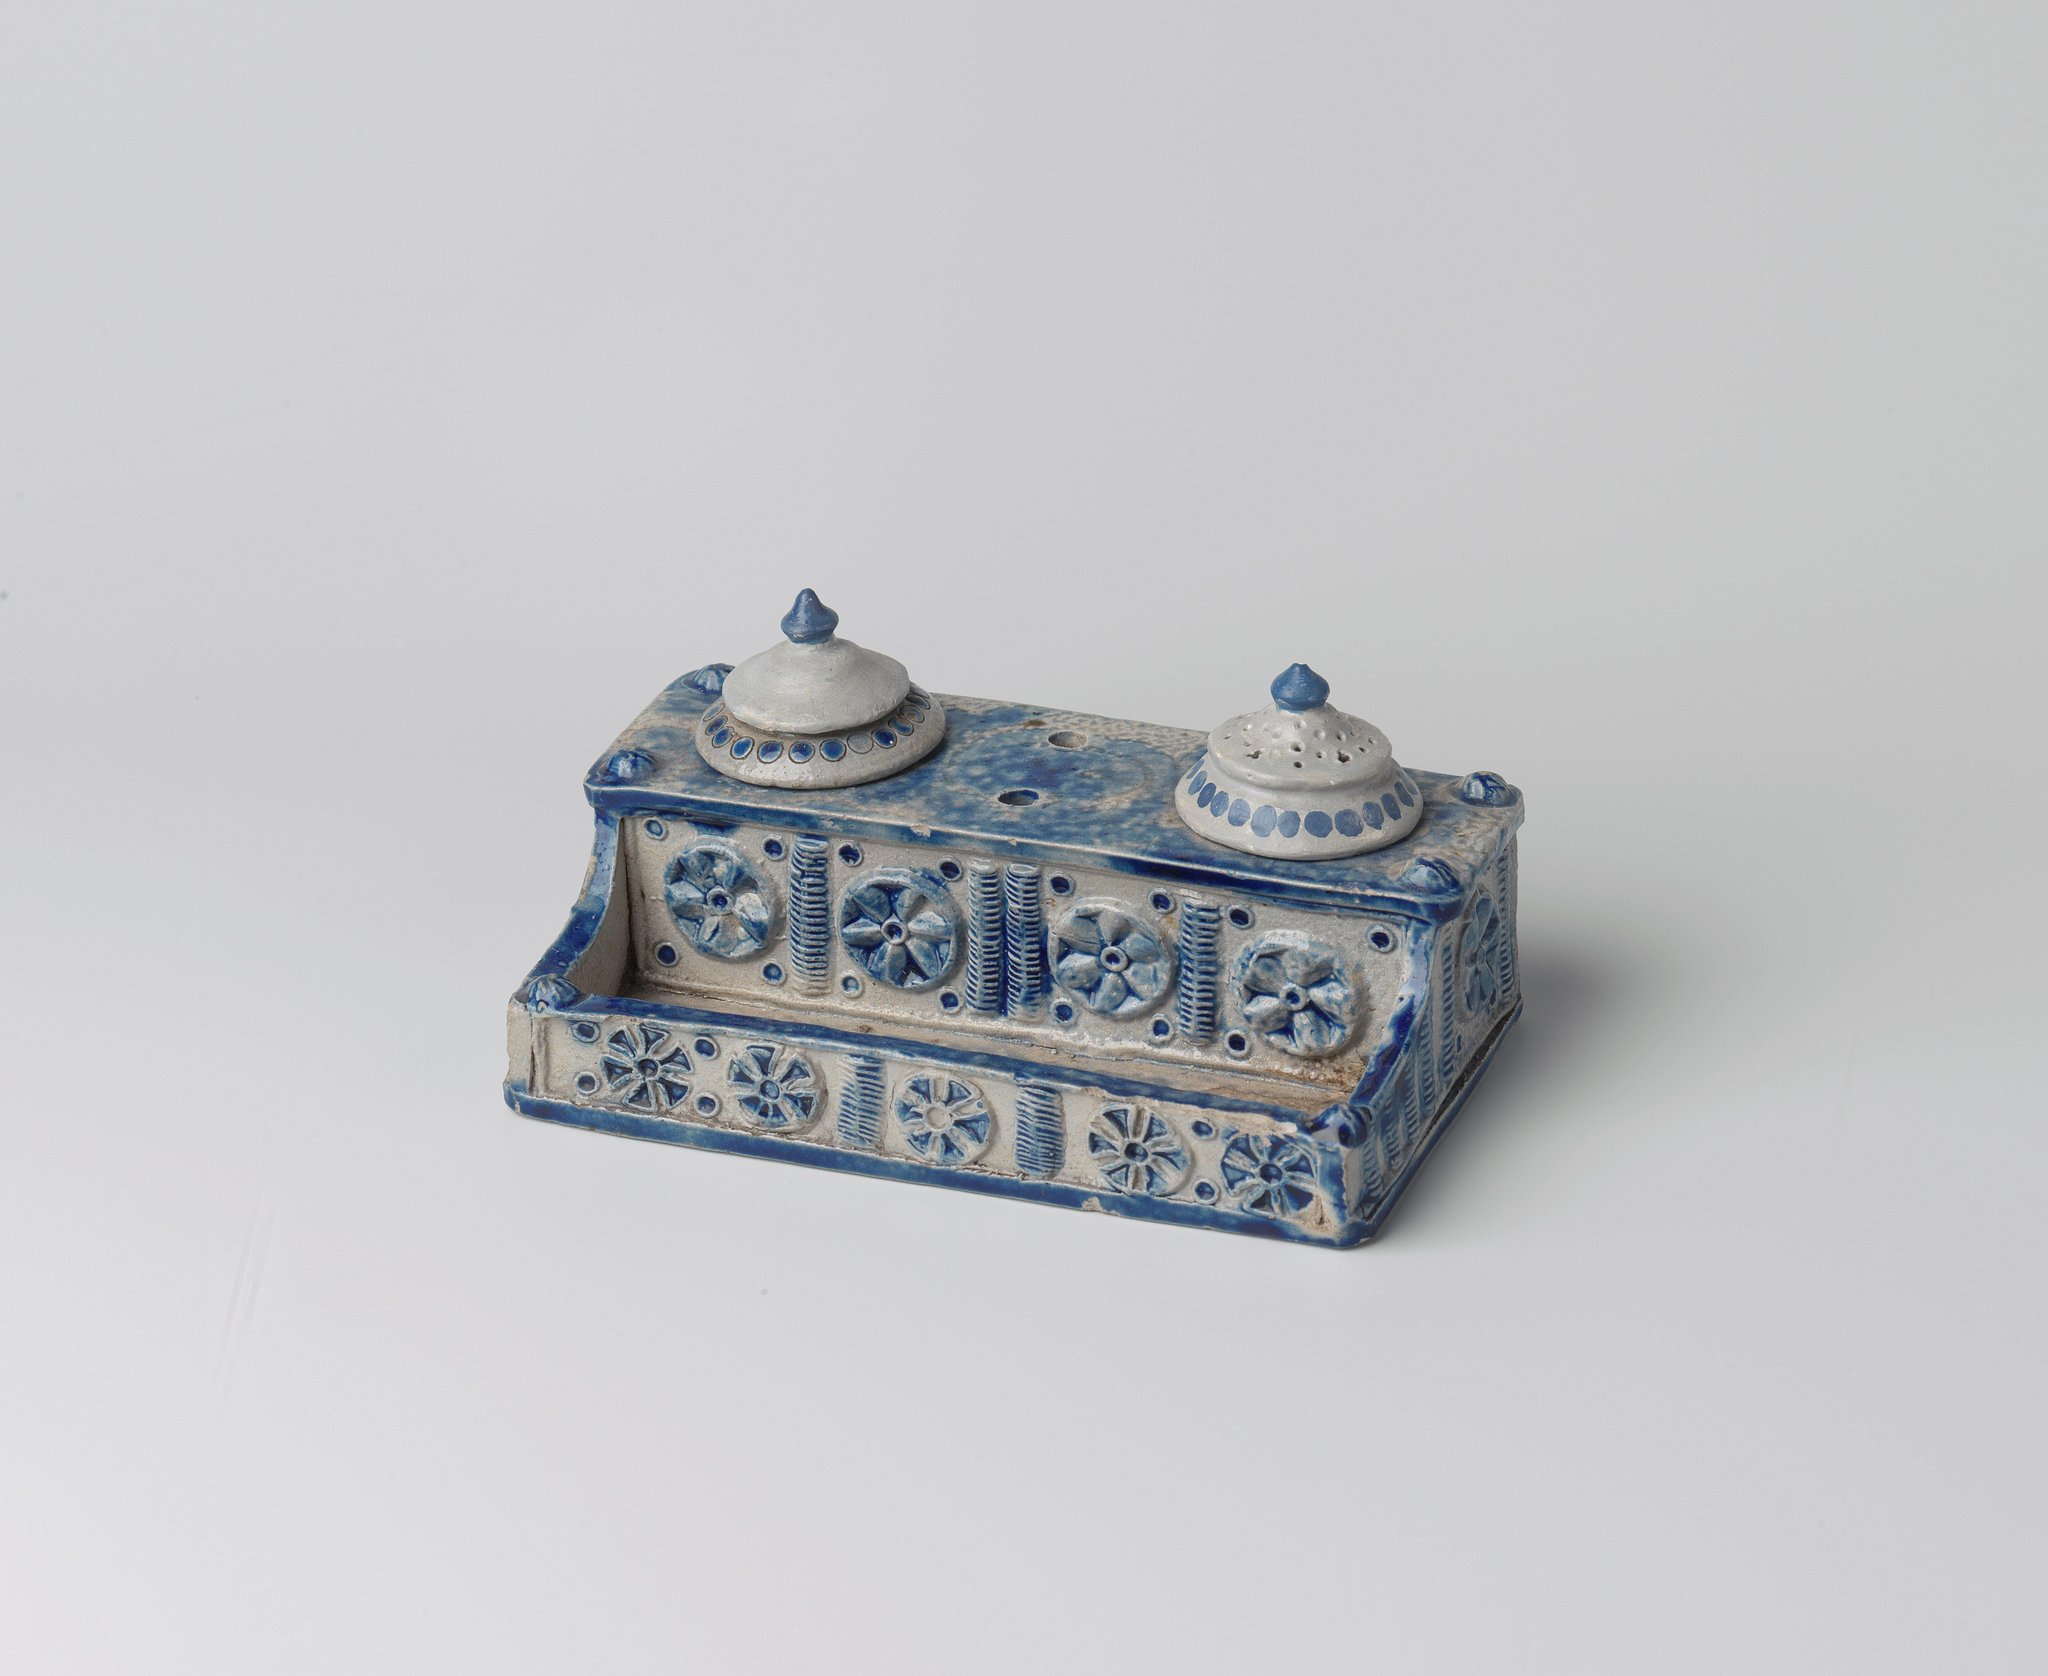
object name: inkstand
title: Ink well with circles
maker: Anonymous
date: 1750-1799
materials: cobalt, glaze, gypsum, stoneware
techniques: printing, firing, turning, vitrification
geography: westerwald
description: Inktpot van steengoed met een cilindrisch lichaam, uitlopende rand om in de houder te plaatsen en lage, opstaande nek. De rand is versierd met gestempelde cirkels in kobaltblauw. Het gipsen deksel is verlijmd en van later datum. Westerwald.